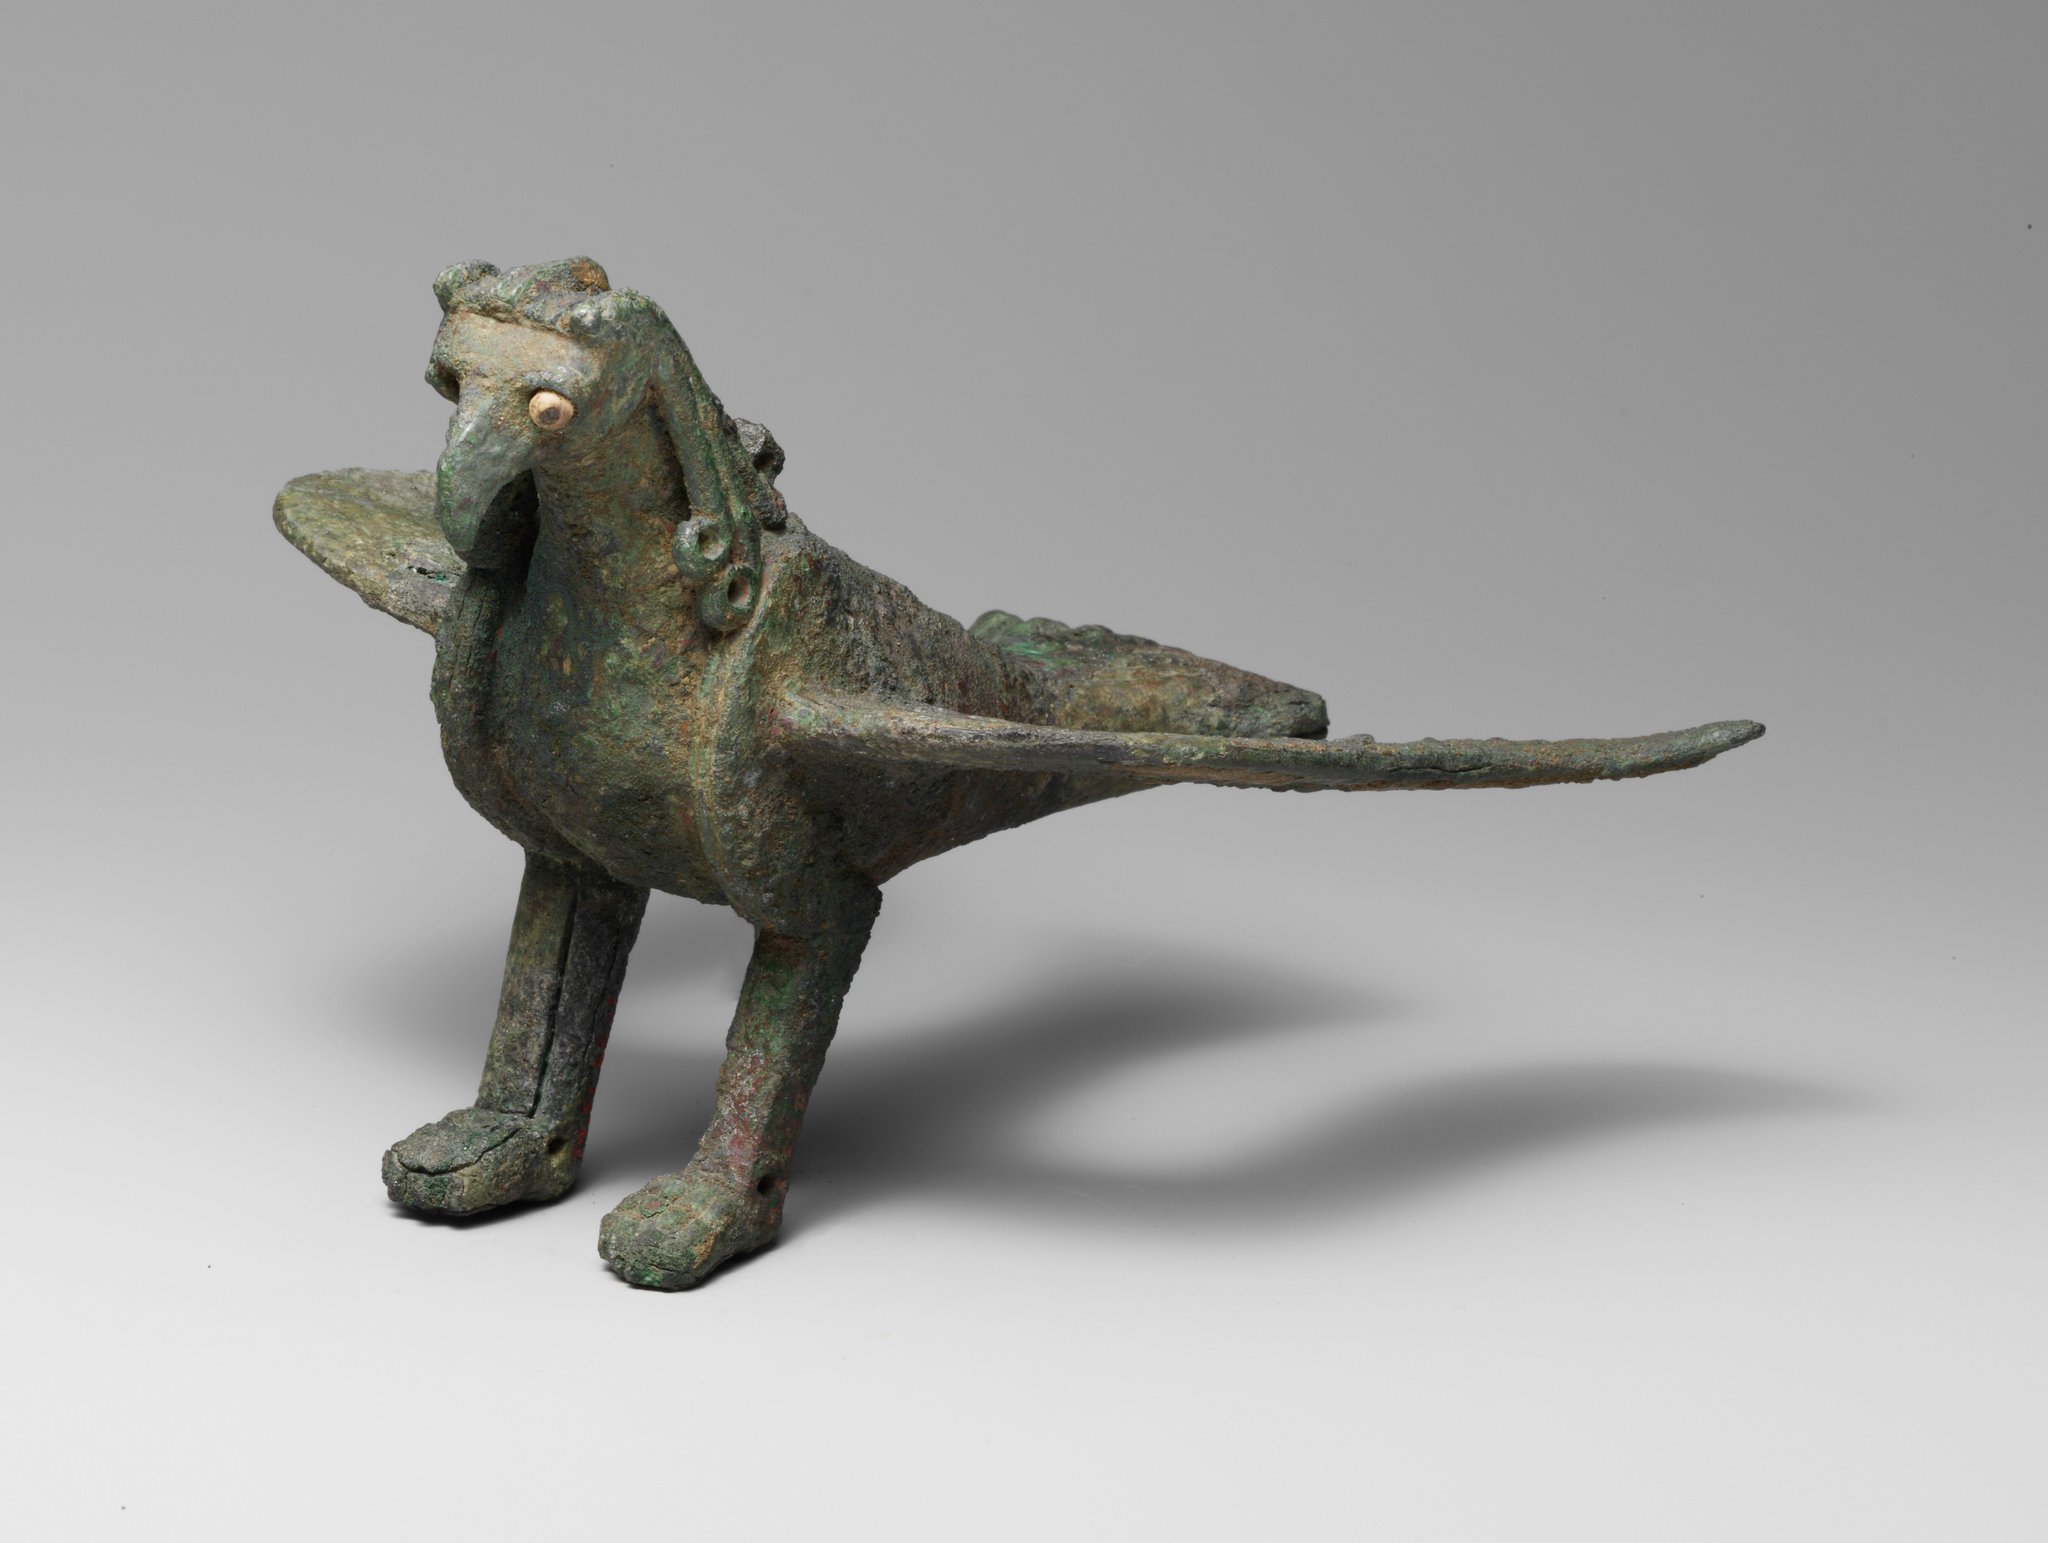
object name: figurine of a bird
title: Bronze statuette of a bird of prey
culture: cypriot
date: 800-601 BCE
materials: bronze, glass, paste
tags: birds